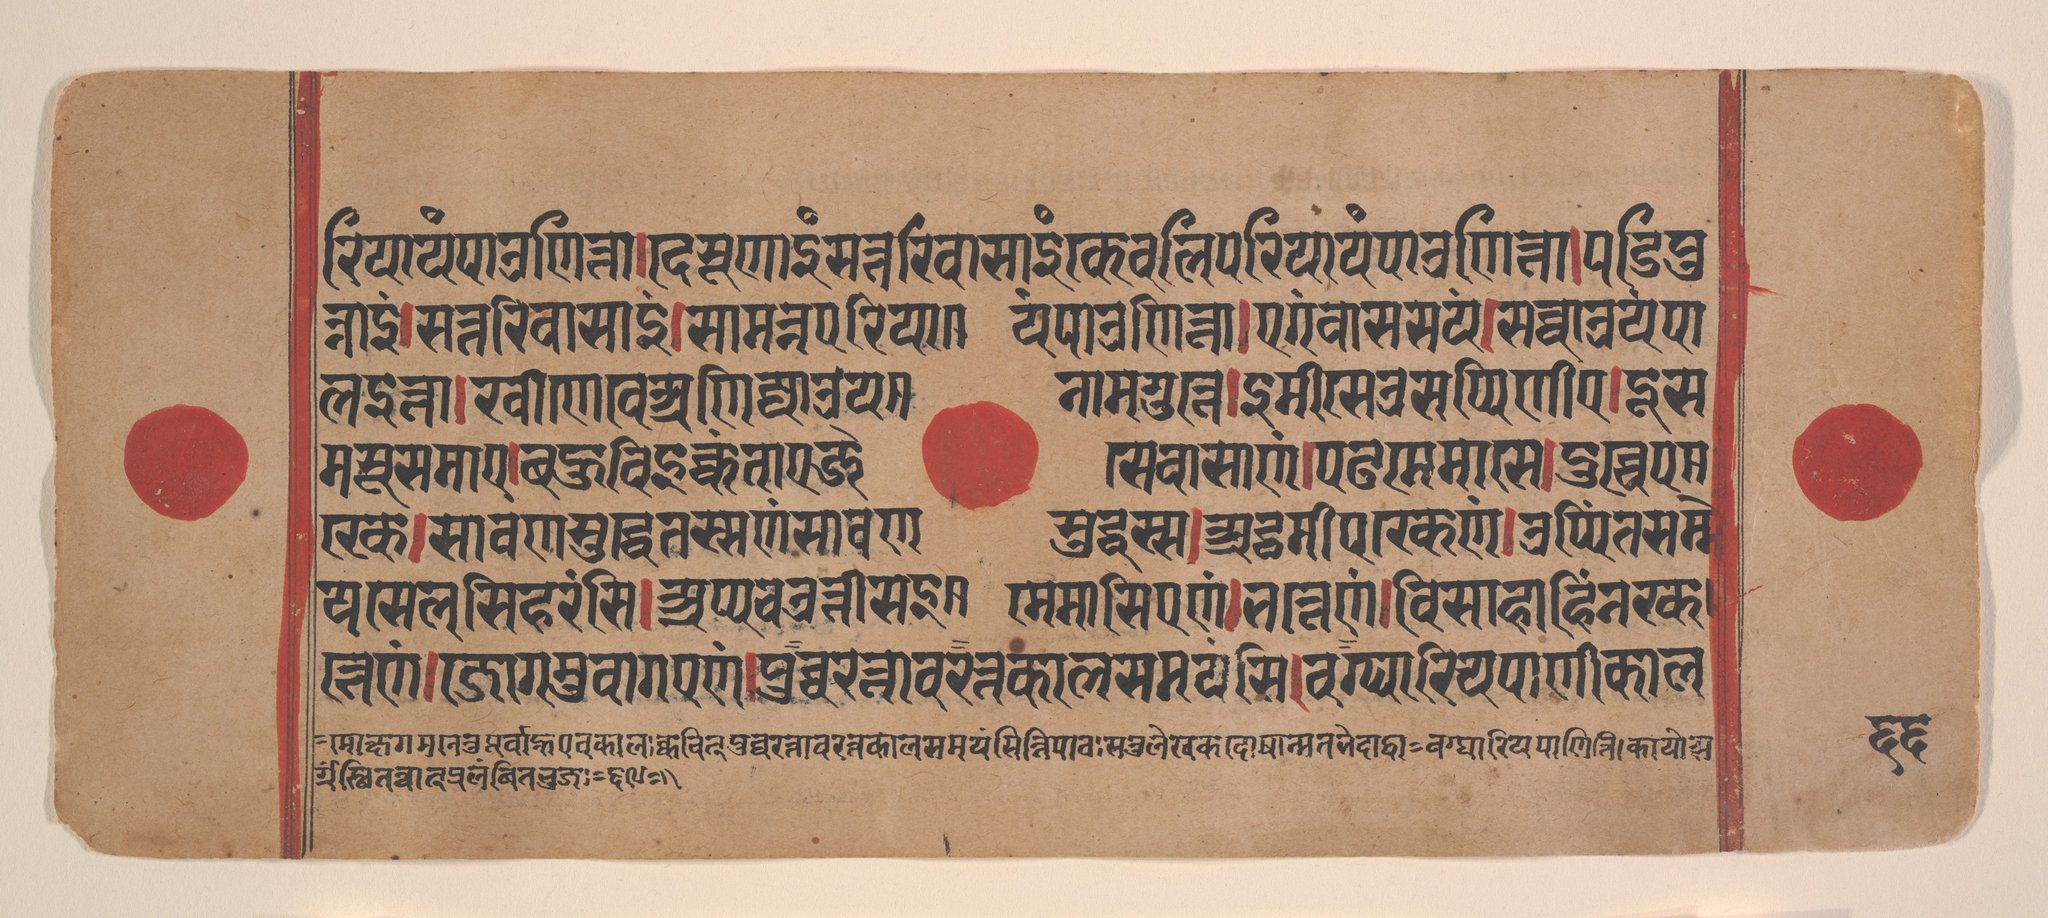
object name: folio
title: Page from a Dispersed Kalpa Sutra (Jain Book of Rituals)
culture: indian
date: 1401-1500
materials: gold, ink, paper, watercolor